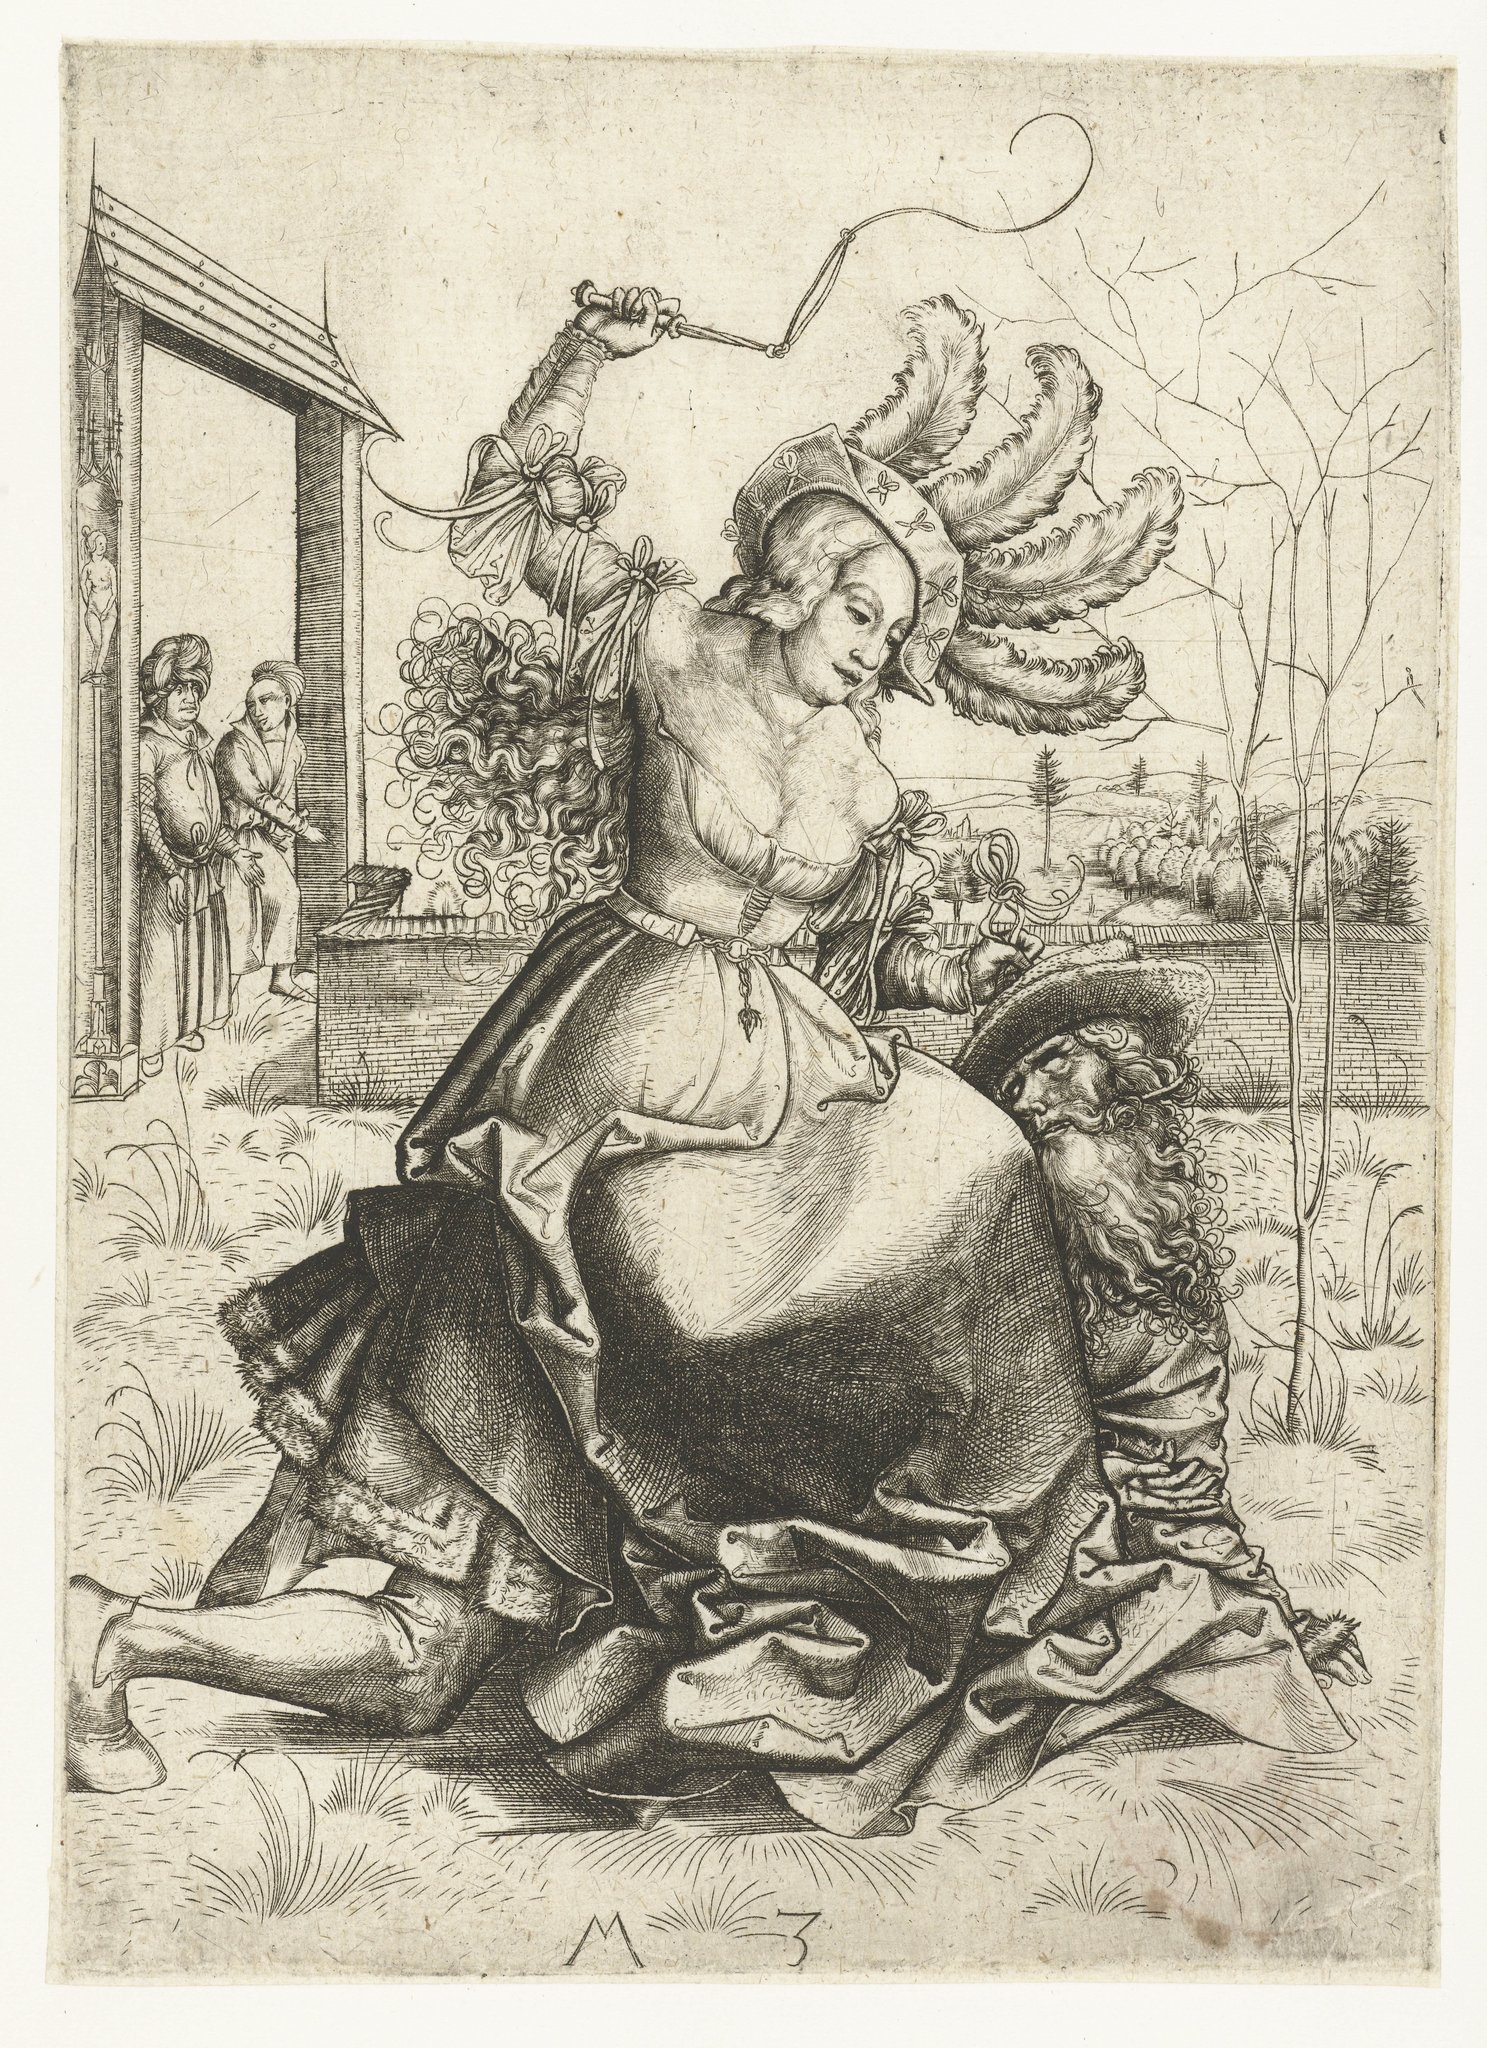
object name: print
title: Aristoteles en Phyllis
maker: monogrammist mz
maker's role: print maker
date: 1500-1503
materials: paper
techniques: engraving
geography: germany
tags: aristotle and phyllis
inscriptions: collector's mark: Lugt 240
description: In een omheinde tuin rijdt een mooie vrouw (Phyllis) op de rug van een bebaarde man (Aristoteles), die op handen en voeten loopt en een bit in de mond heeft. Vanuit een poort kijken twee mannen toe.